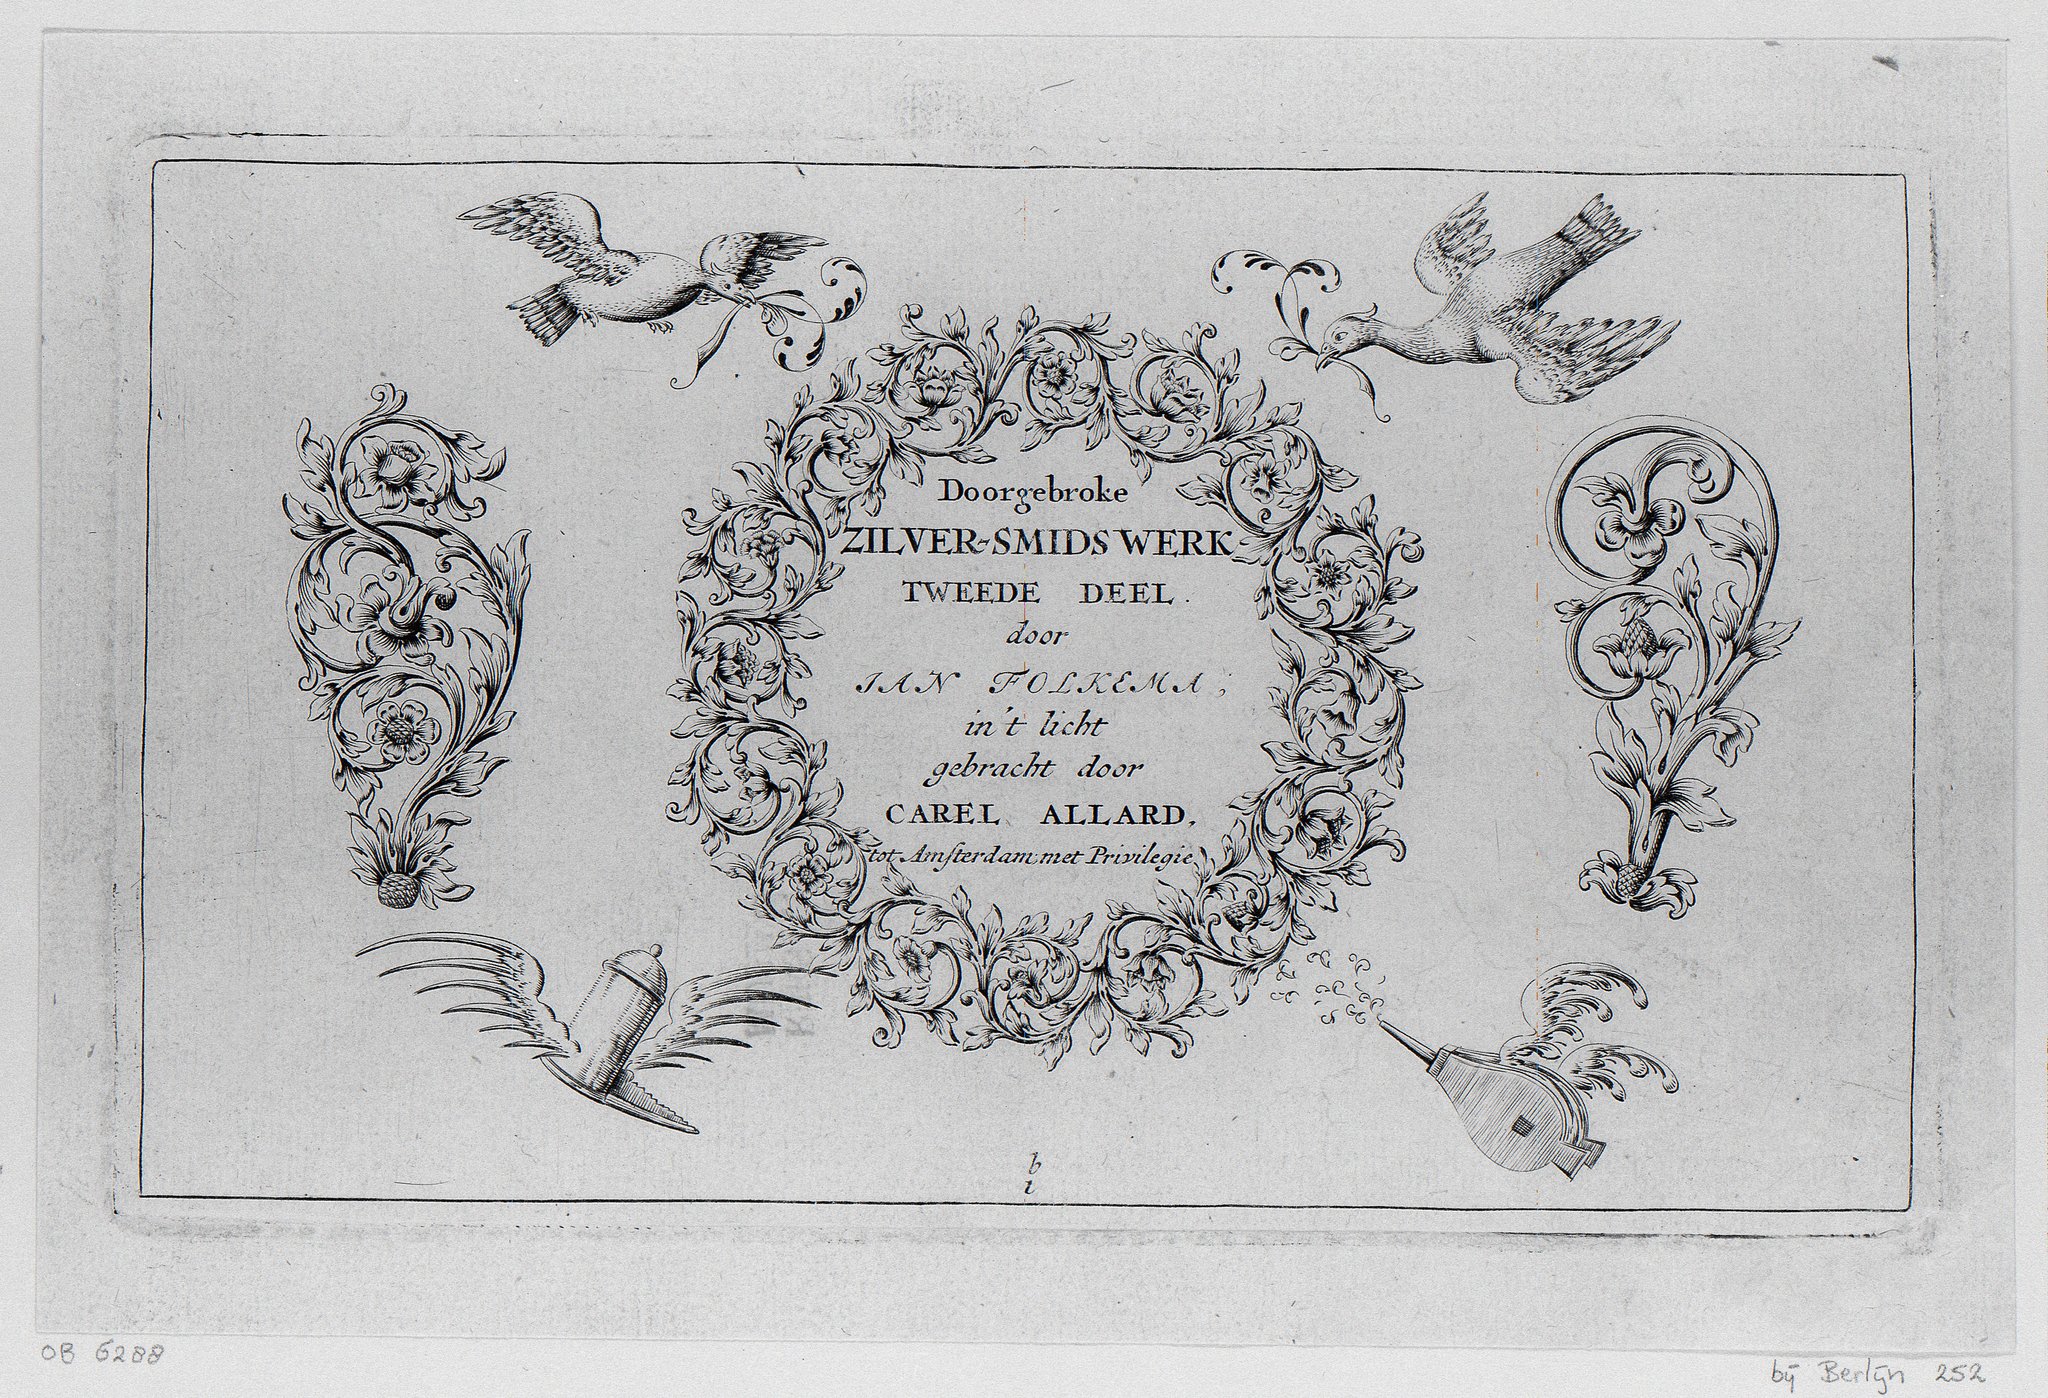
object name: ornament print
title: Doorgebroke Zilver-Smids werk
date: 1690-1700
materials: paper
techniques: engraving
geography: amsterdam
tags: ornament derived from plant forms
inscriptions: title: ‘Doorgebroken Zilver-Smids Werk-Tweede Deel door Jan Folkema in 't licht gebracht door Carel Allard’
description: Titel in ronde omlijsting van bloemenranken, met aan weerszijden een vogel, bloemornamenten en een gevleugelde blaasbalg. Blad uit tweede serie van 6 bladen met voorbeelden van ornamenten voor zilversmeden.